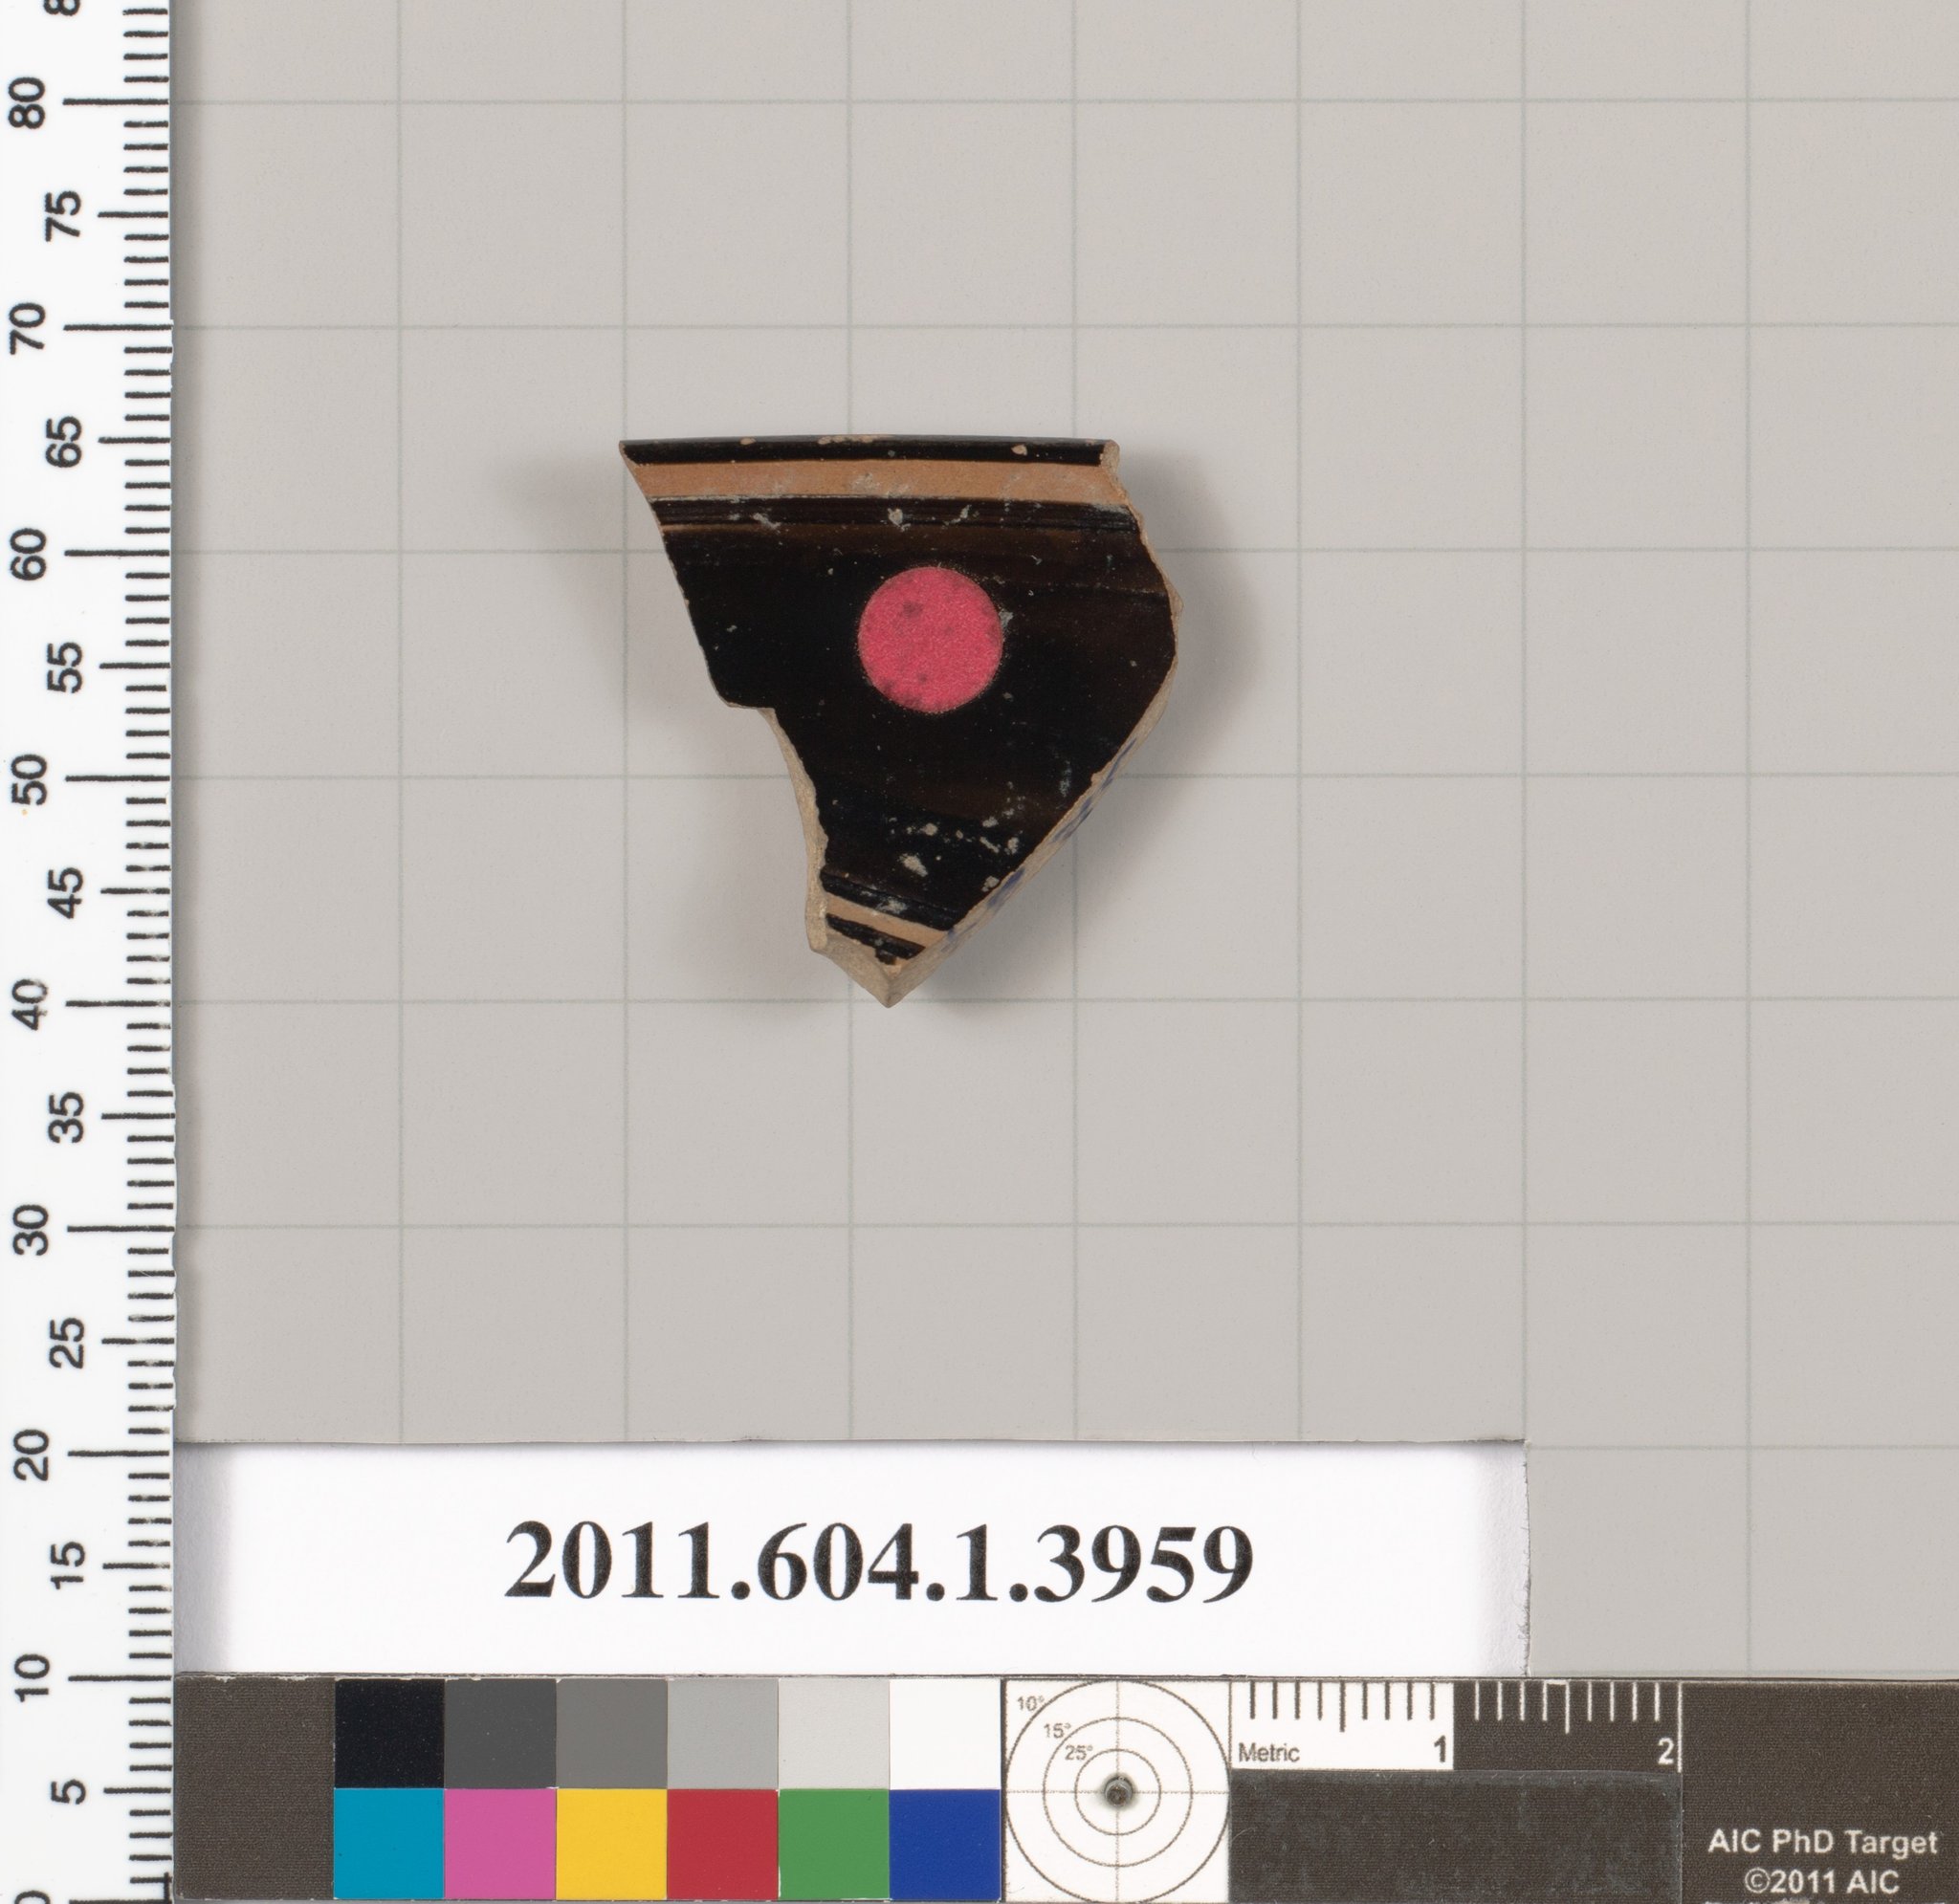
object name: kylix fragment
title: Terracotta fragment of a kylix (drinking cup)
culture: greek, attic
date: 475-451 BCE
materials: terracotta